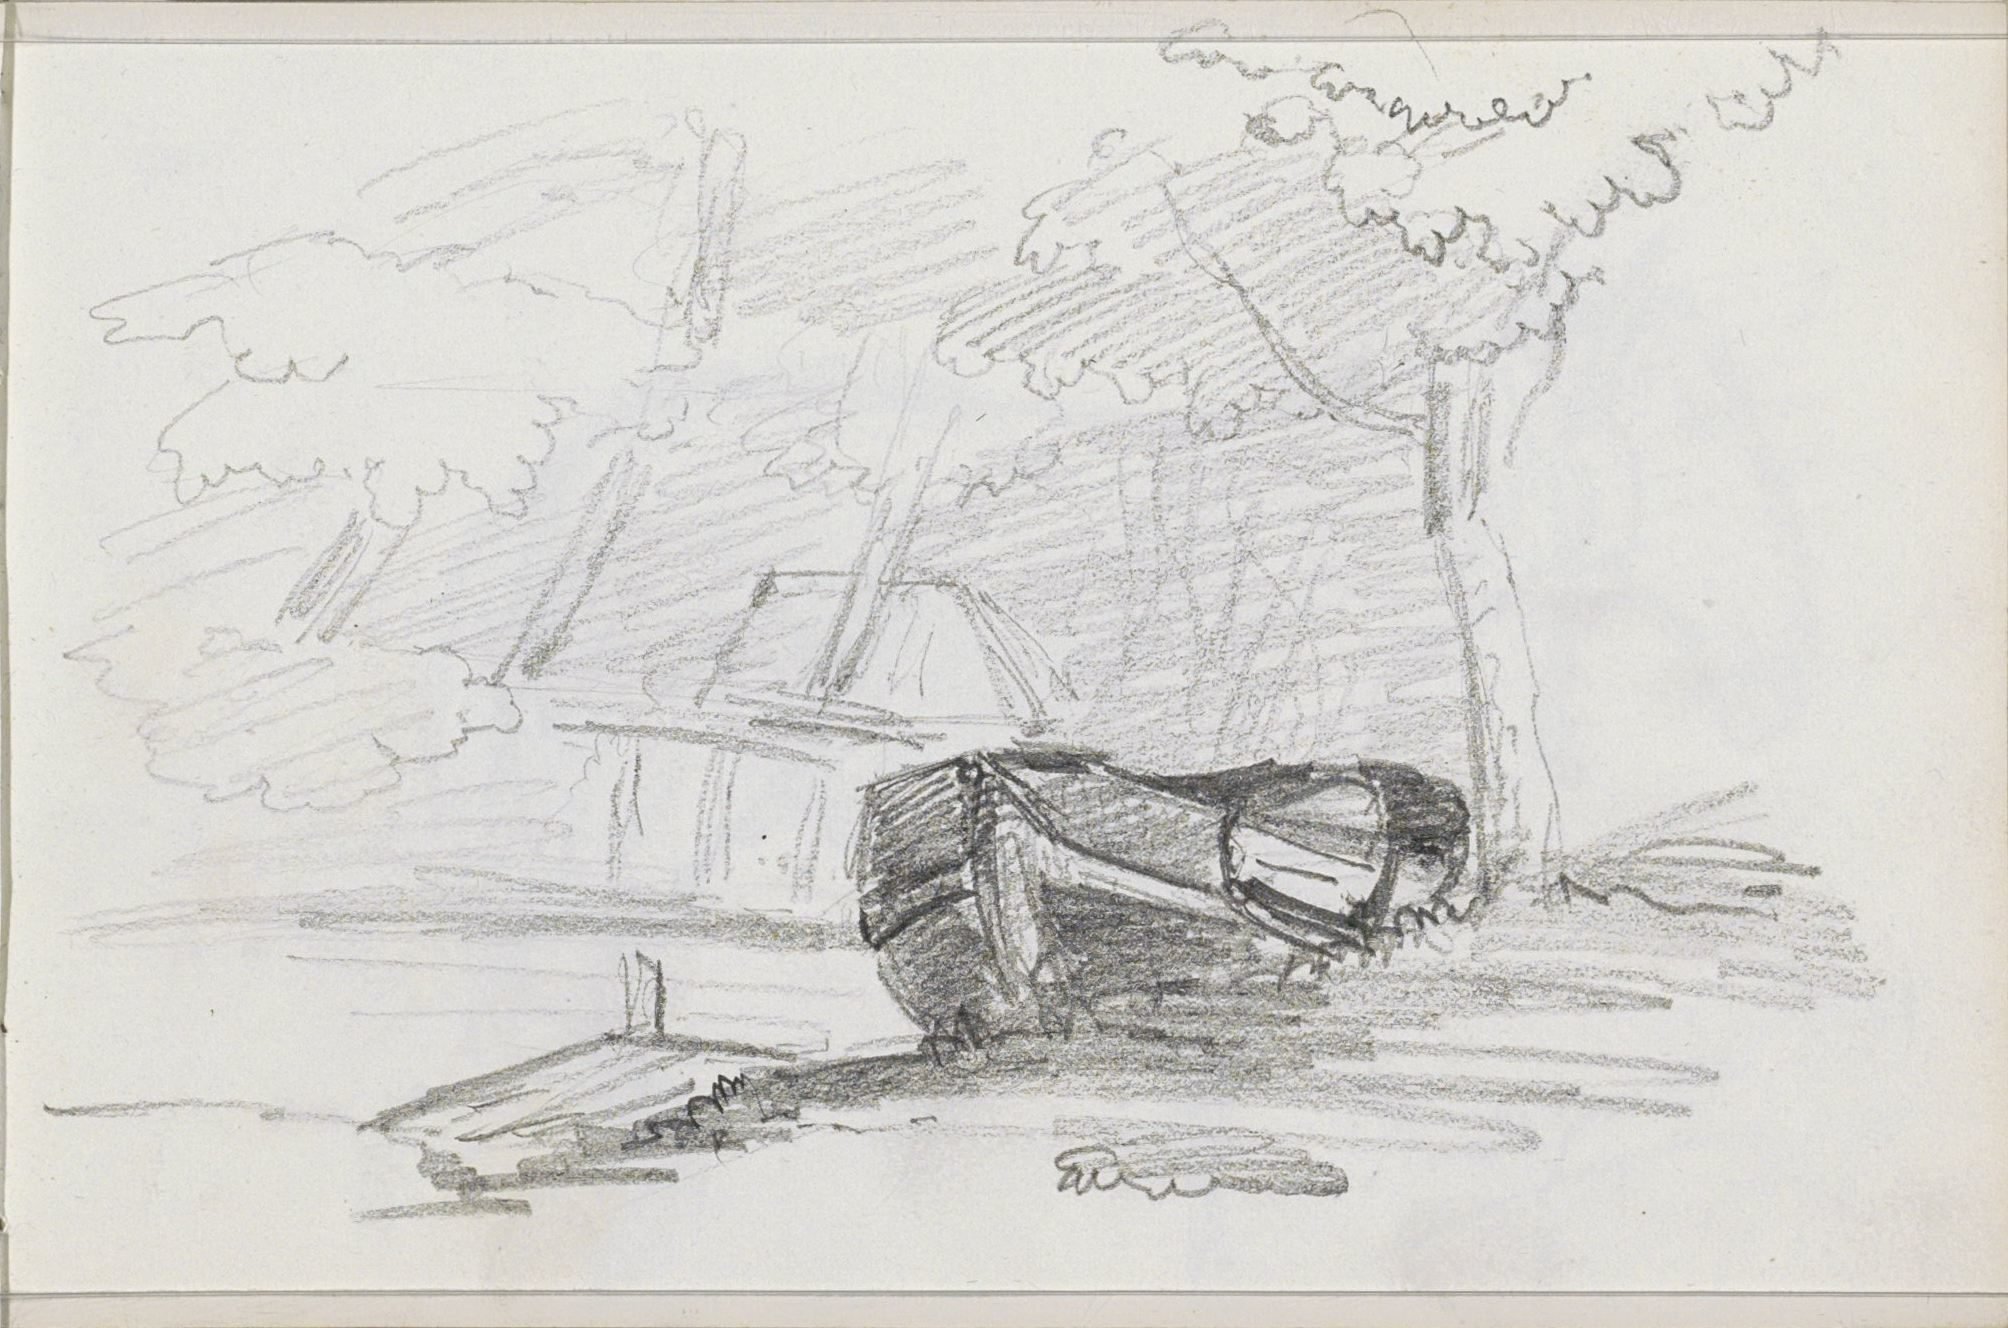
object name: sketchbook leaf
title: Roeiboot naast een boom bij een waterkant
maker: isaac gosschalk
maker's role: draughtsman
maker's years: 1838-1907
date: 1860-1861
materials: paper, pencil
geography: switzerland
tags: landscapes with waters, waterscapes, seascapes (in the temperate zone), rowing-boat, canoe, etc., switzerland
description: Op de achtergrond een huis. Blad 10 recto uit een schetsboek met 29 bladen.